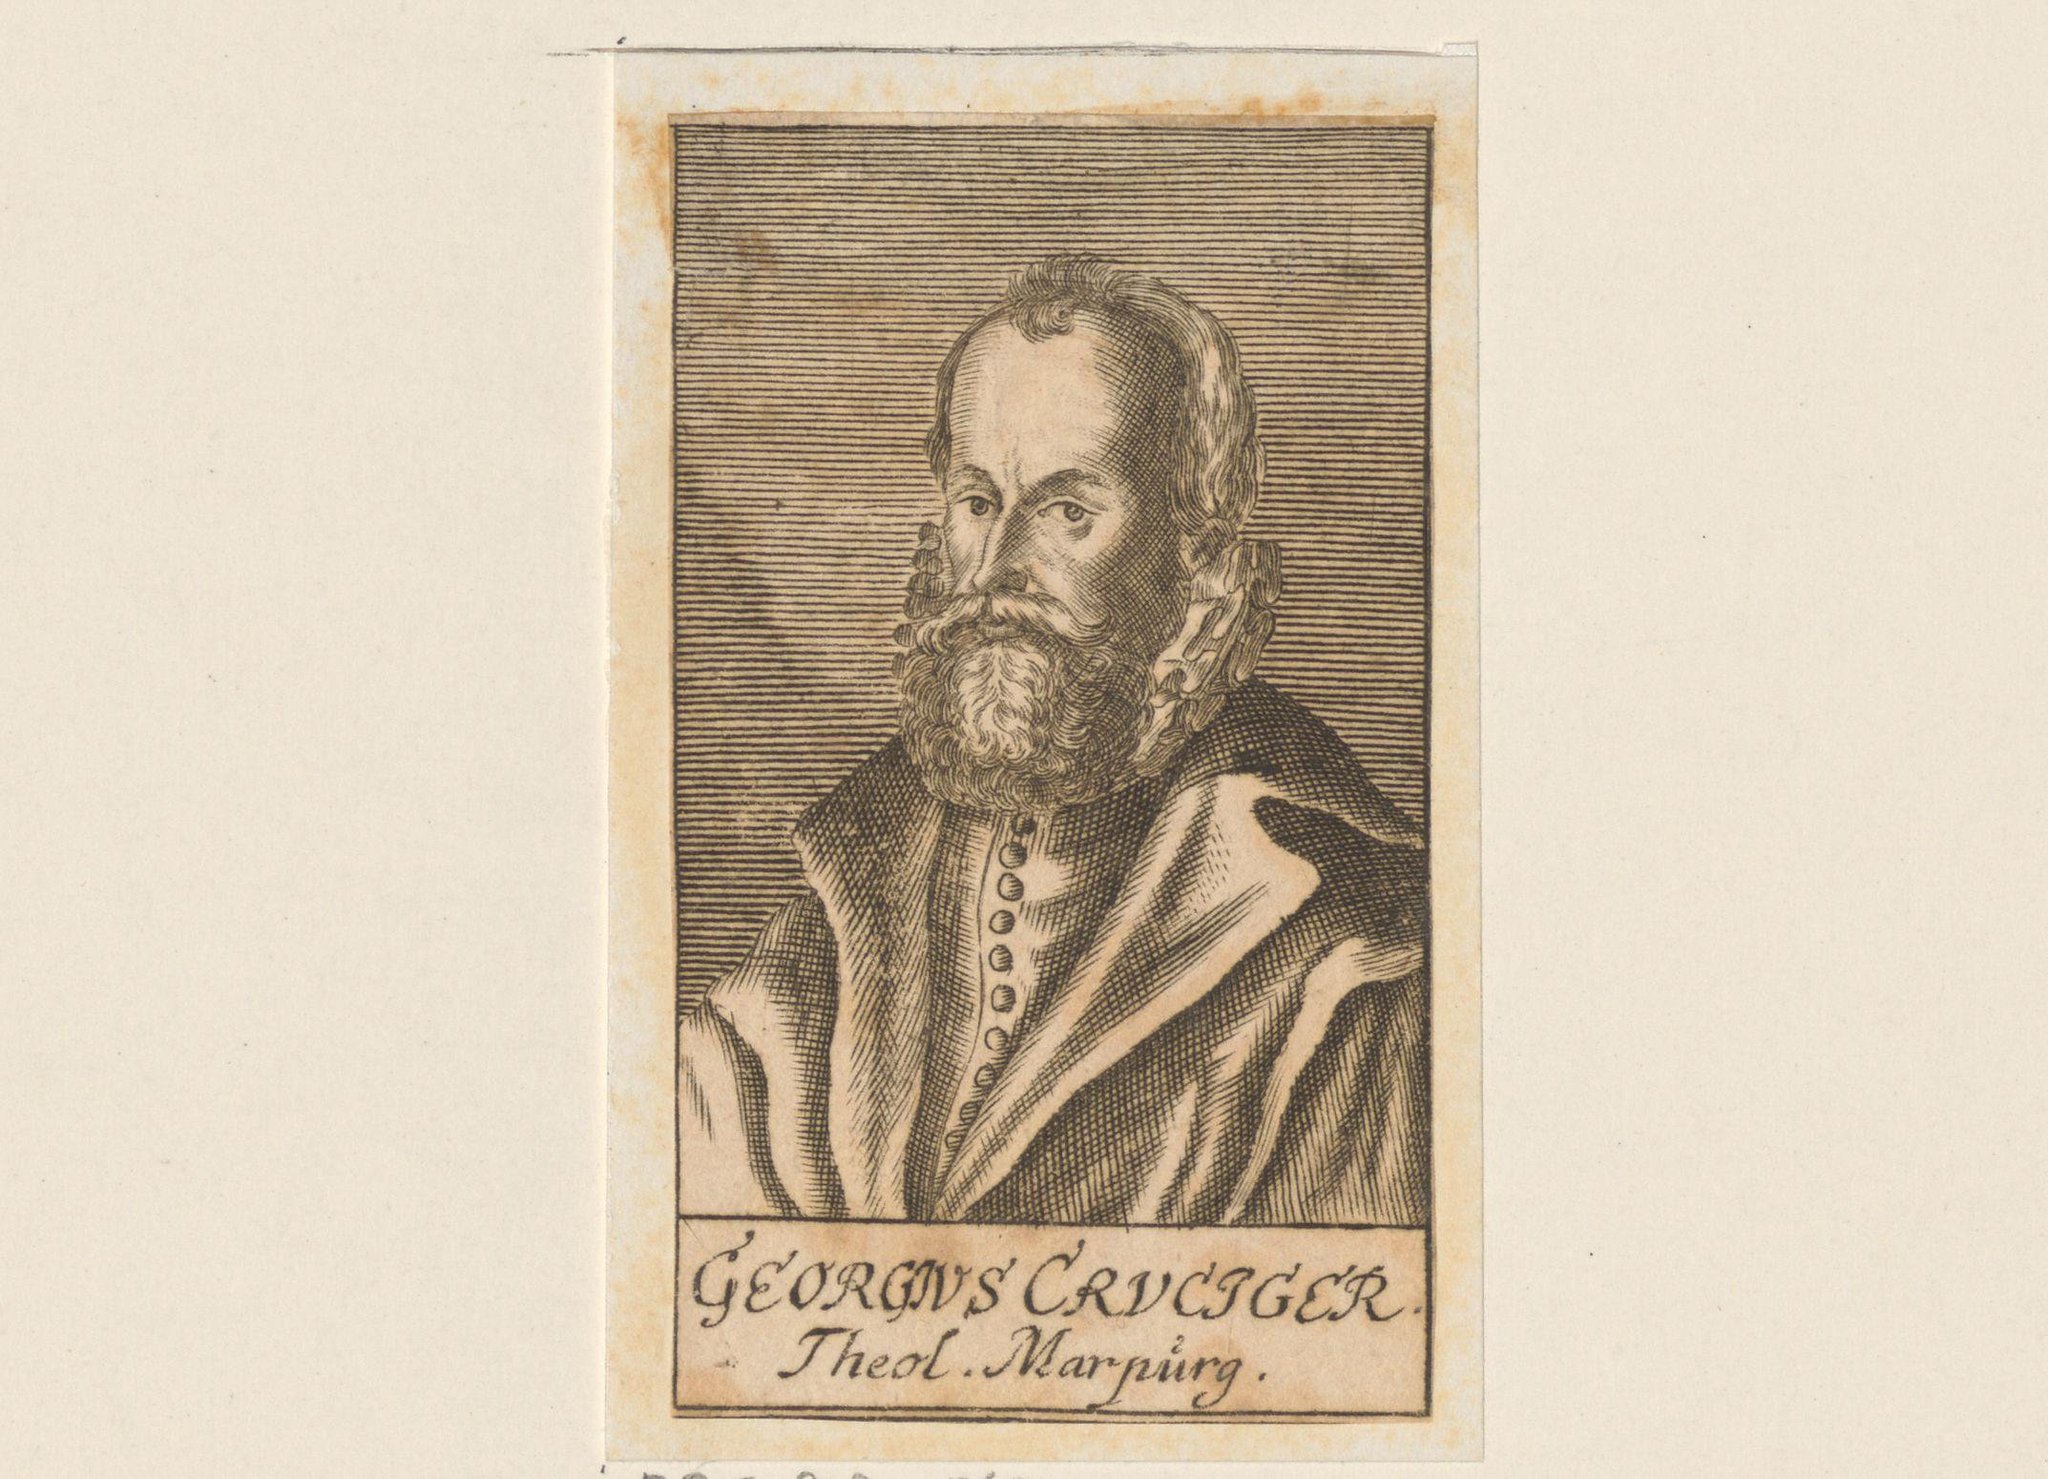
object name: print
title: Portret van Georg Cruciger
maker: Anonymous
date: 1688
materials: paper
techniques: engraving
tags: historical persons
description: Prent maakt deel uit van een grotere prent die later is verknipt. Prent waarschijnlijk uit: Freher, Paul. Theatrum virorum eruditione clarorum. Neurenberg: Johann Hoffmann, 1688.